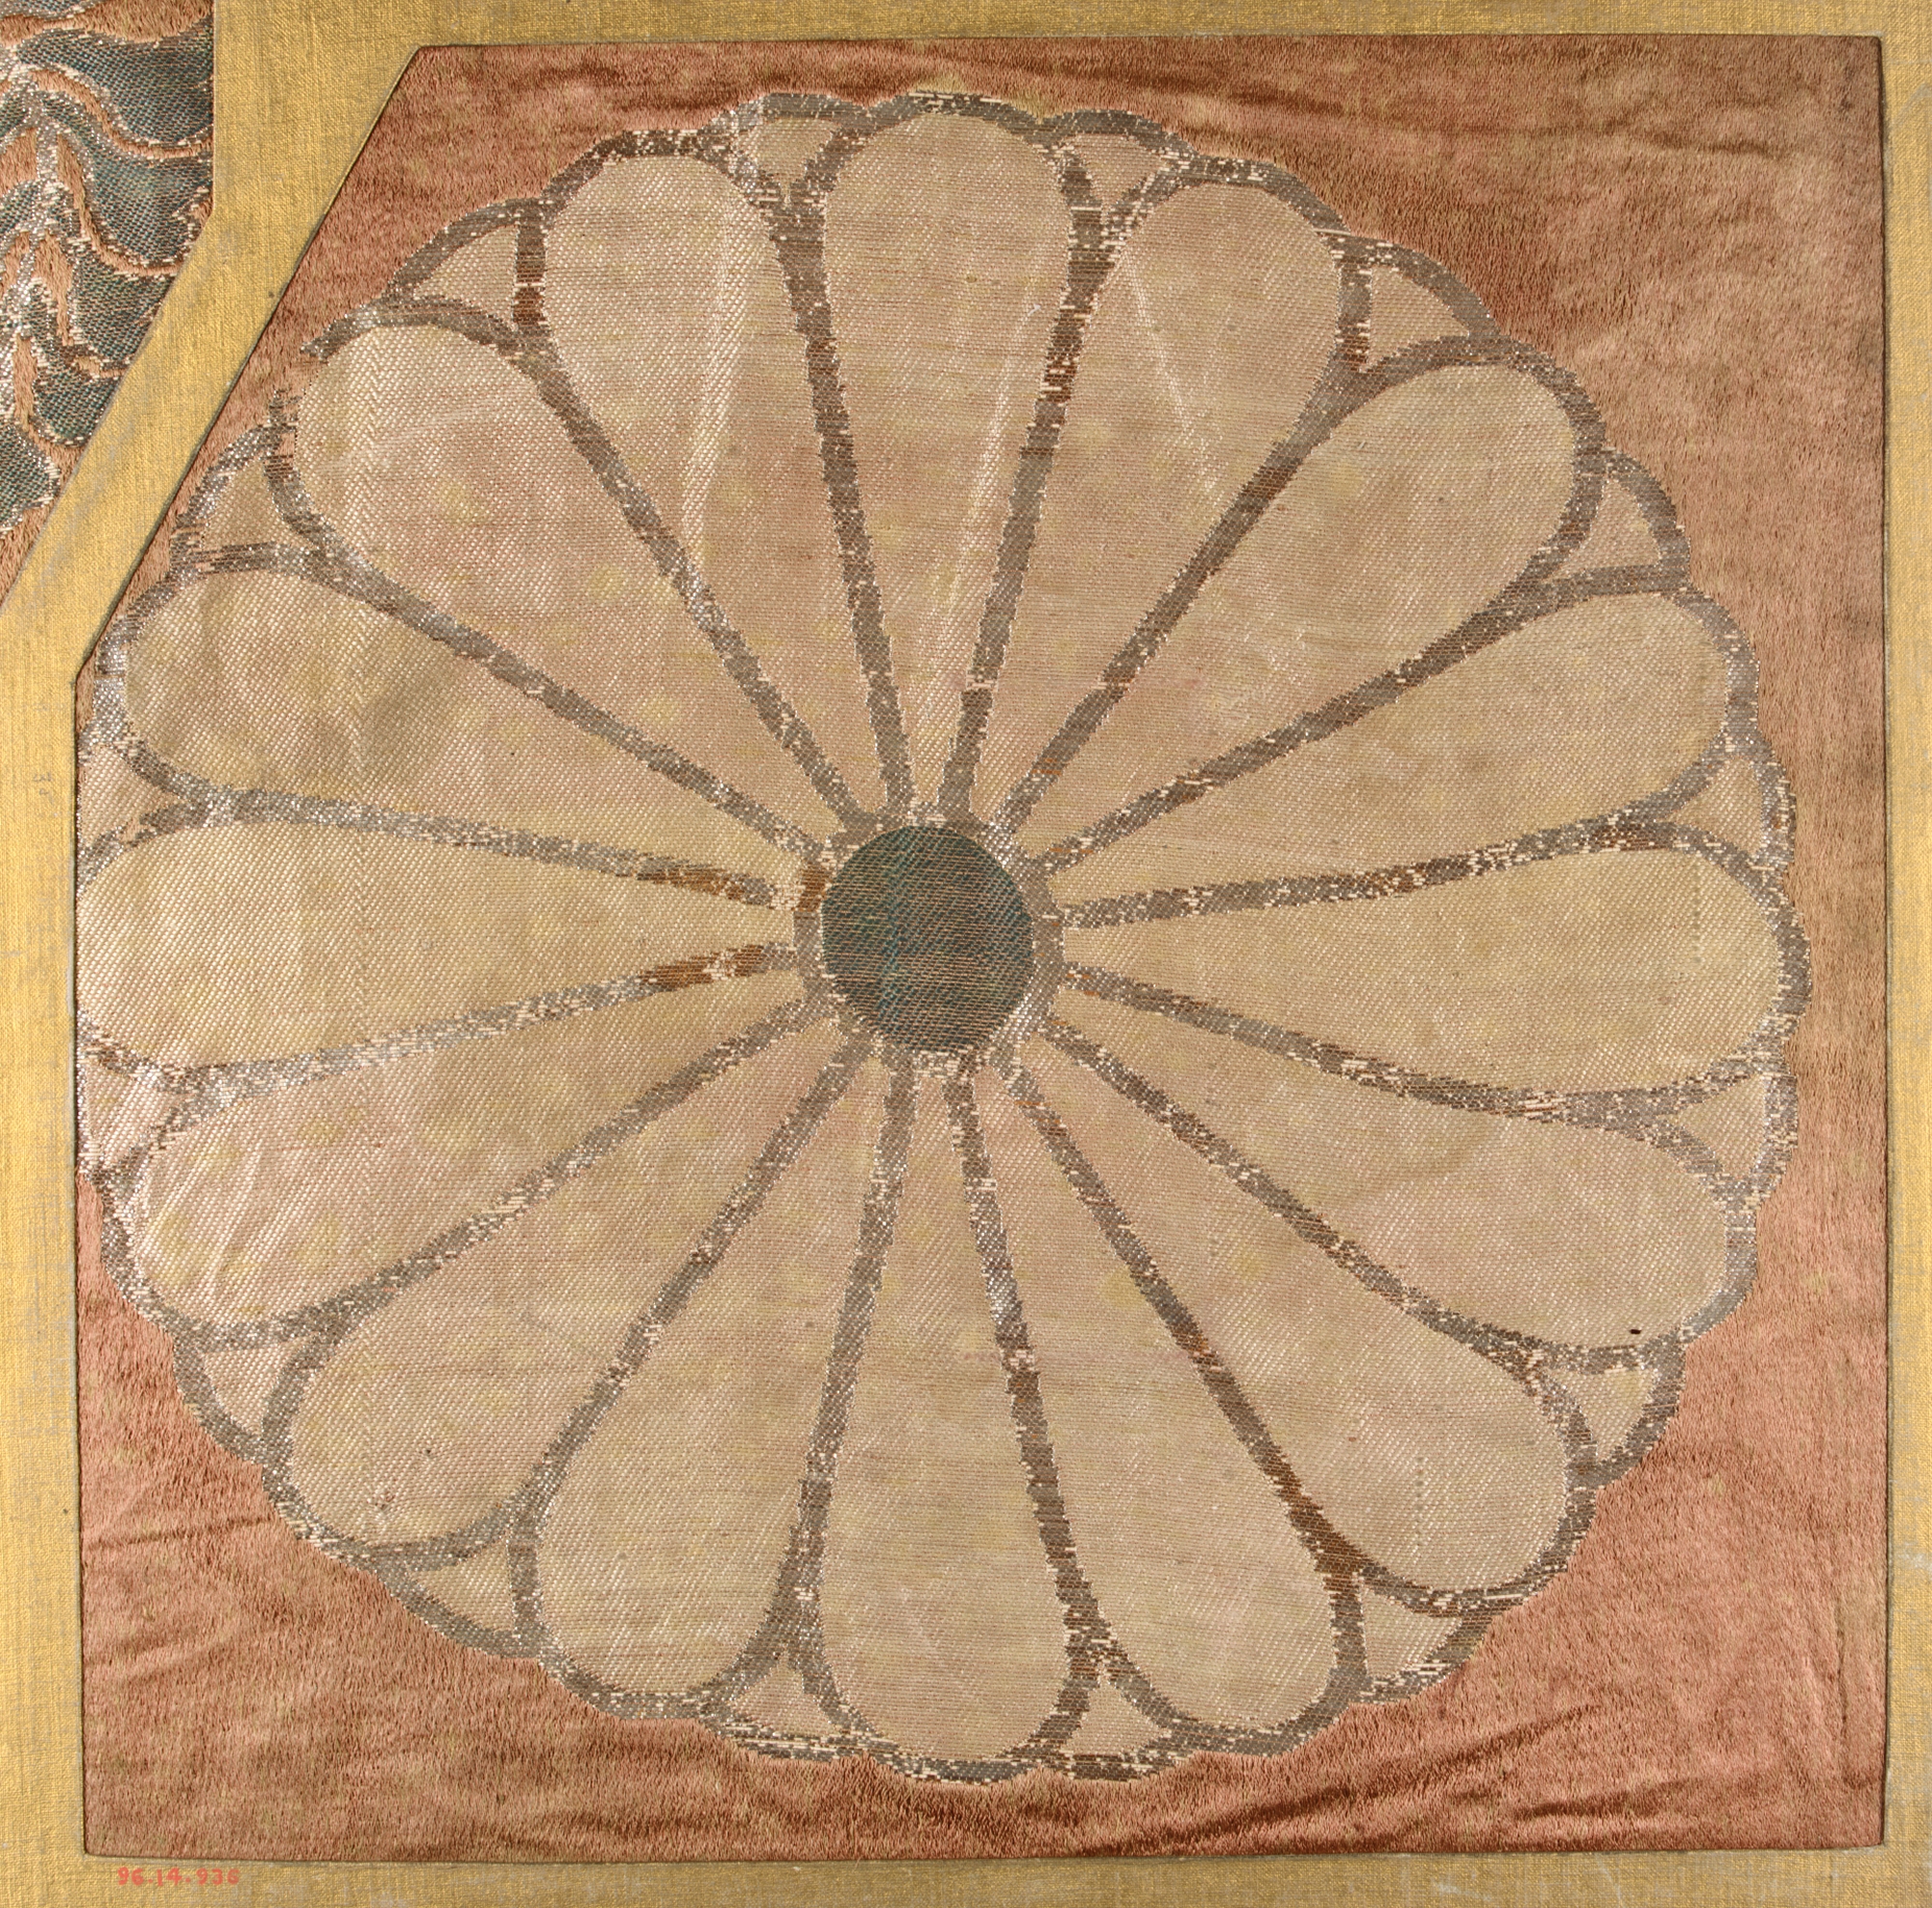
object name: piece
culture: japanese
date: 1701-1900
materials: silk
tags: flowers